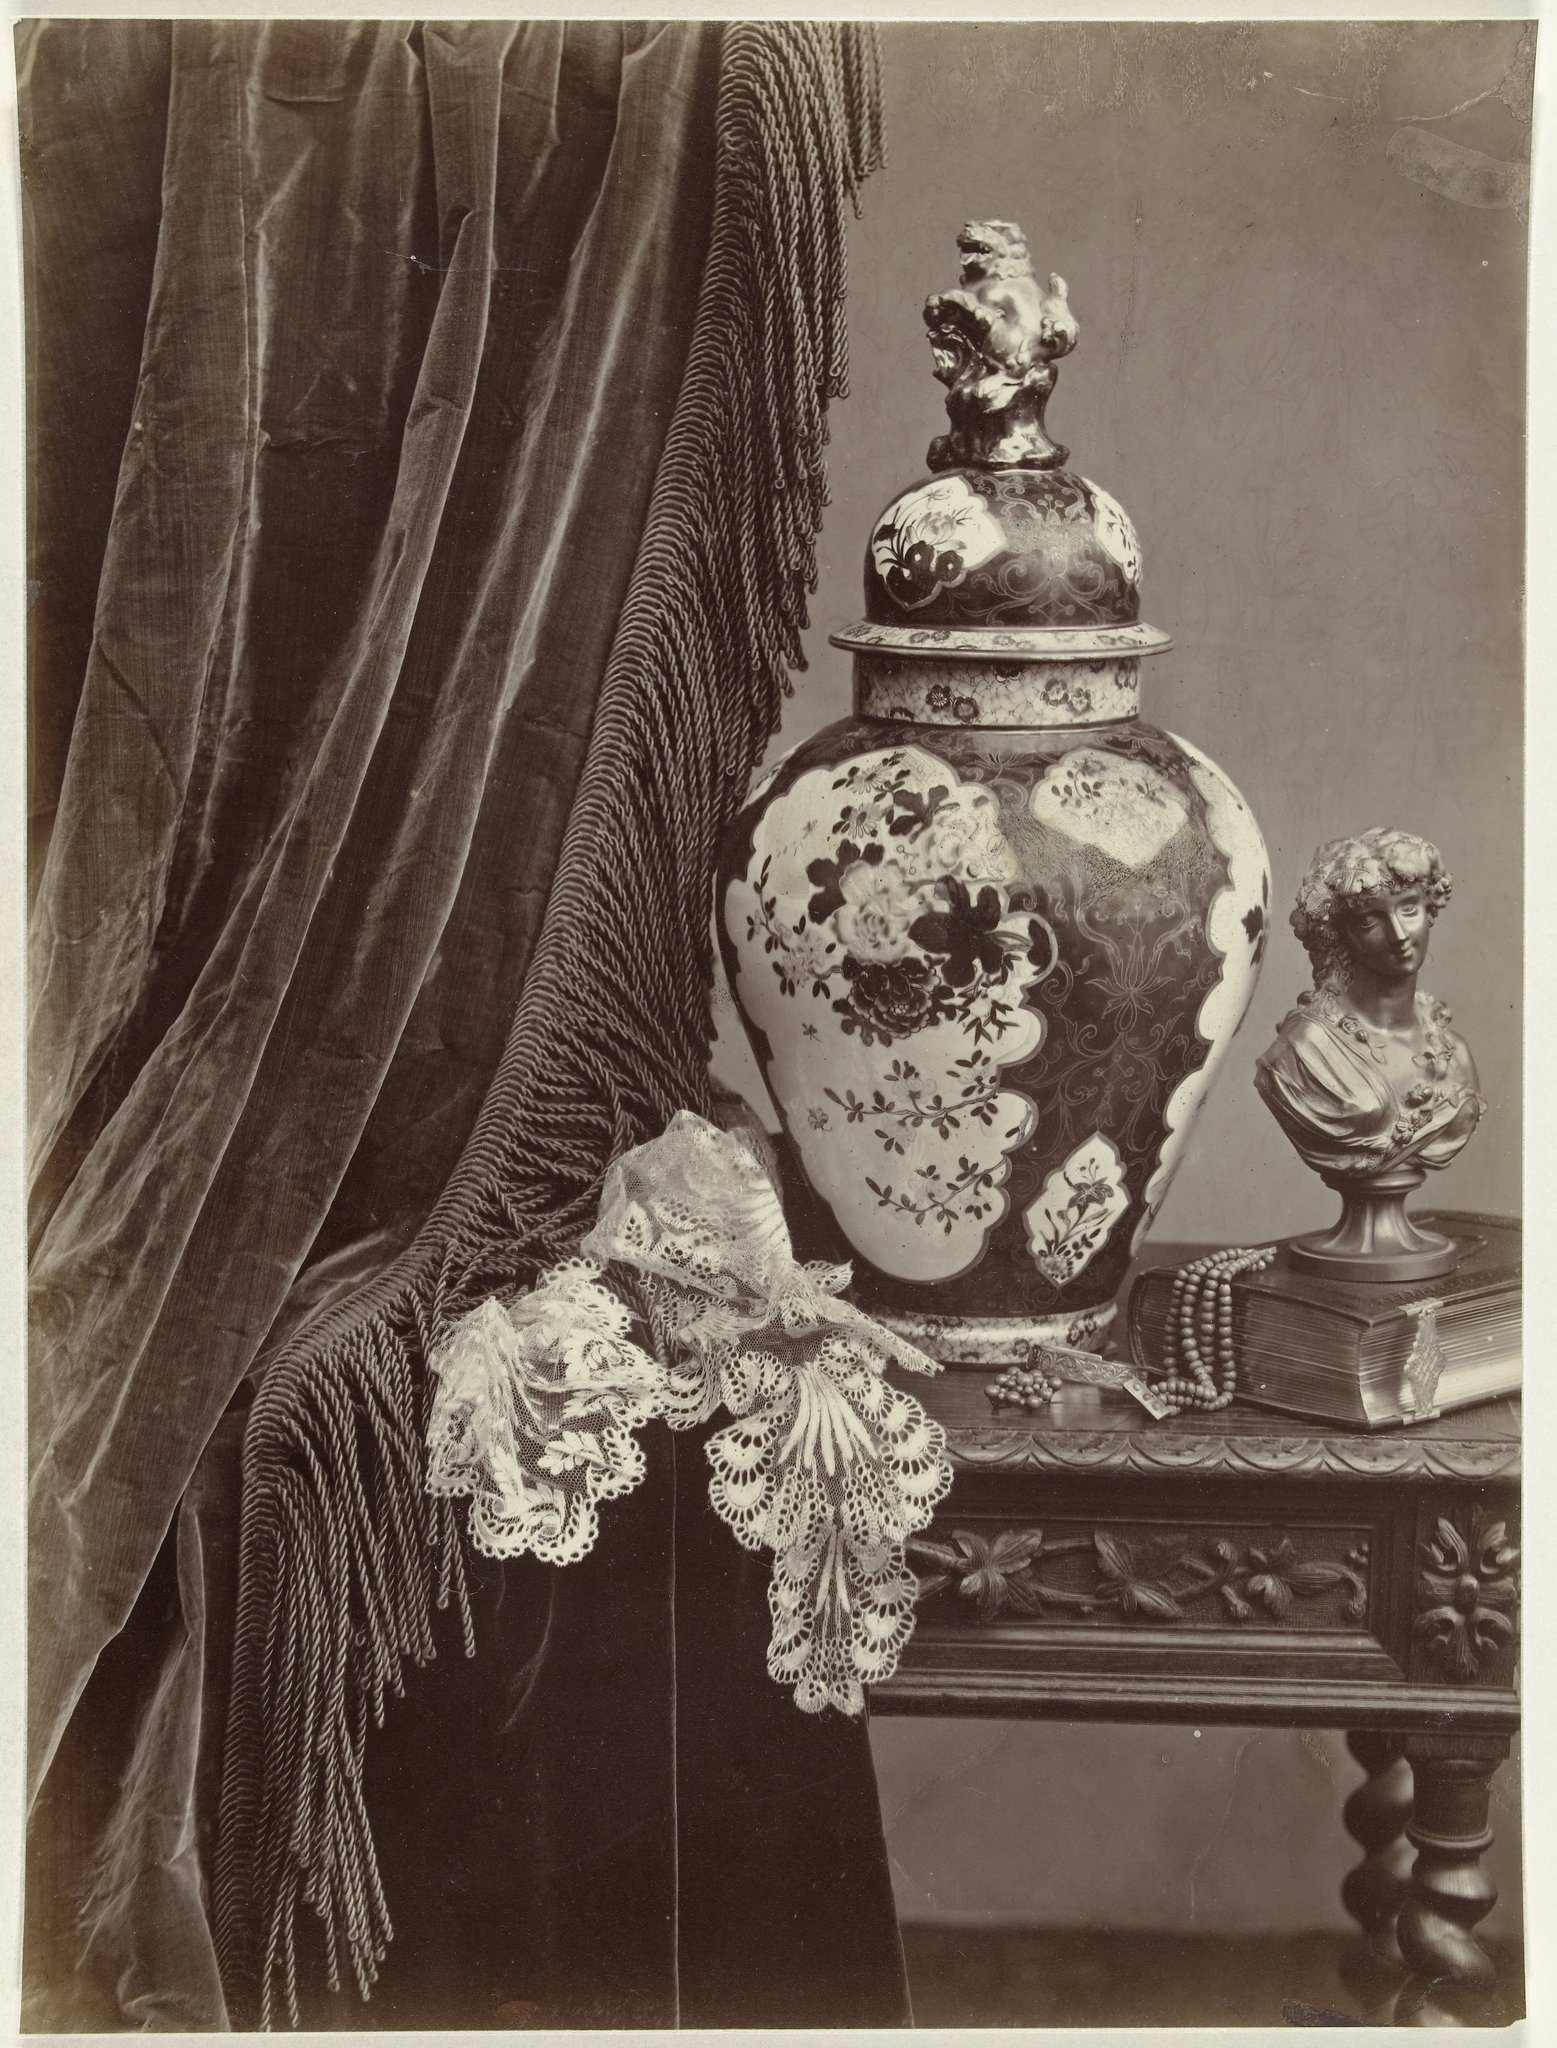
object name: photograph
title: Stilleven met gordijn, kant, vaas en buste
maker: Anonymous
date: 1870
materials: paper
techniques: carbon print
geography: france